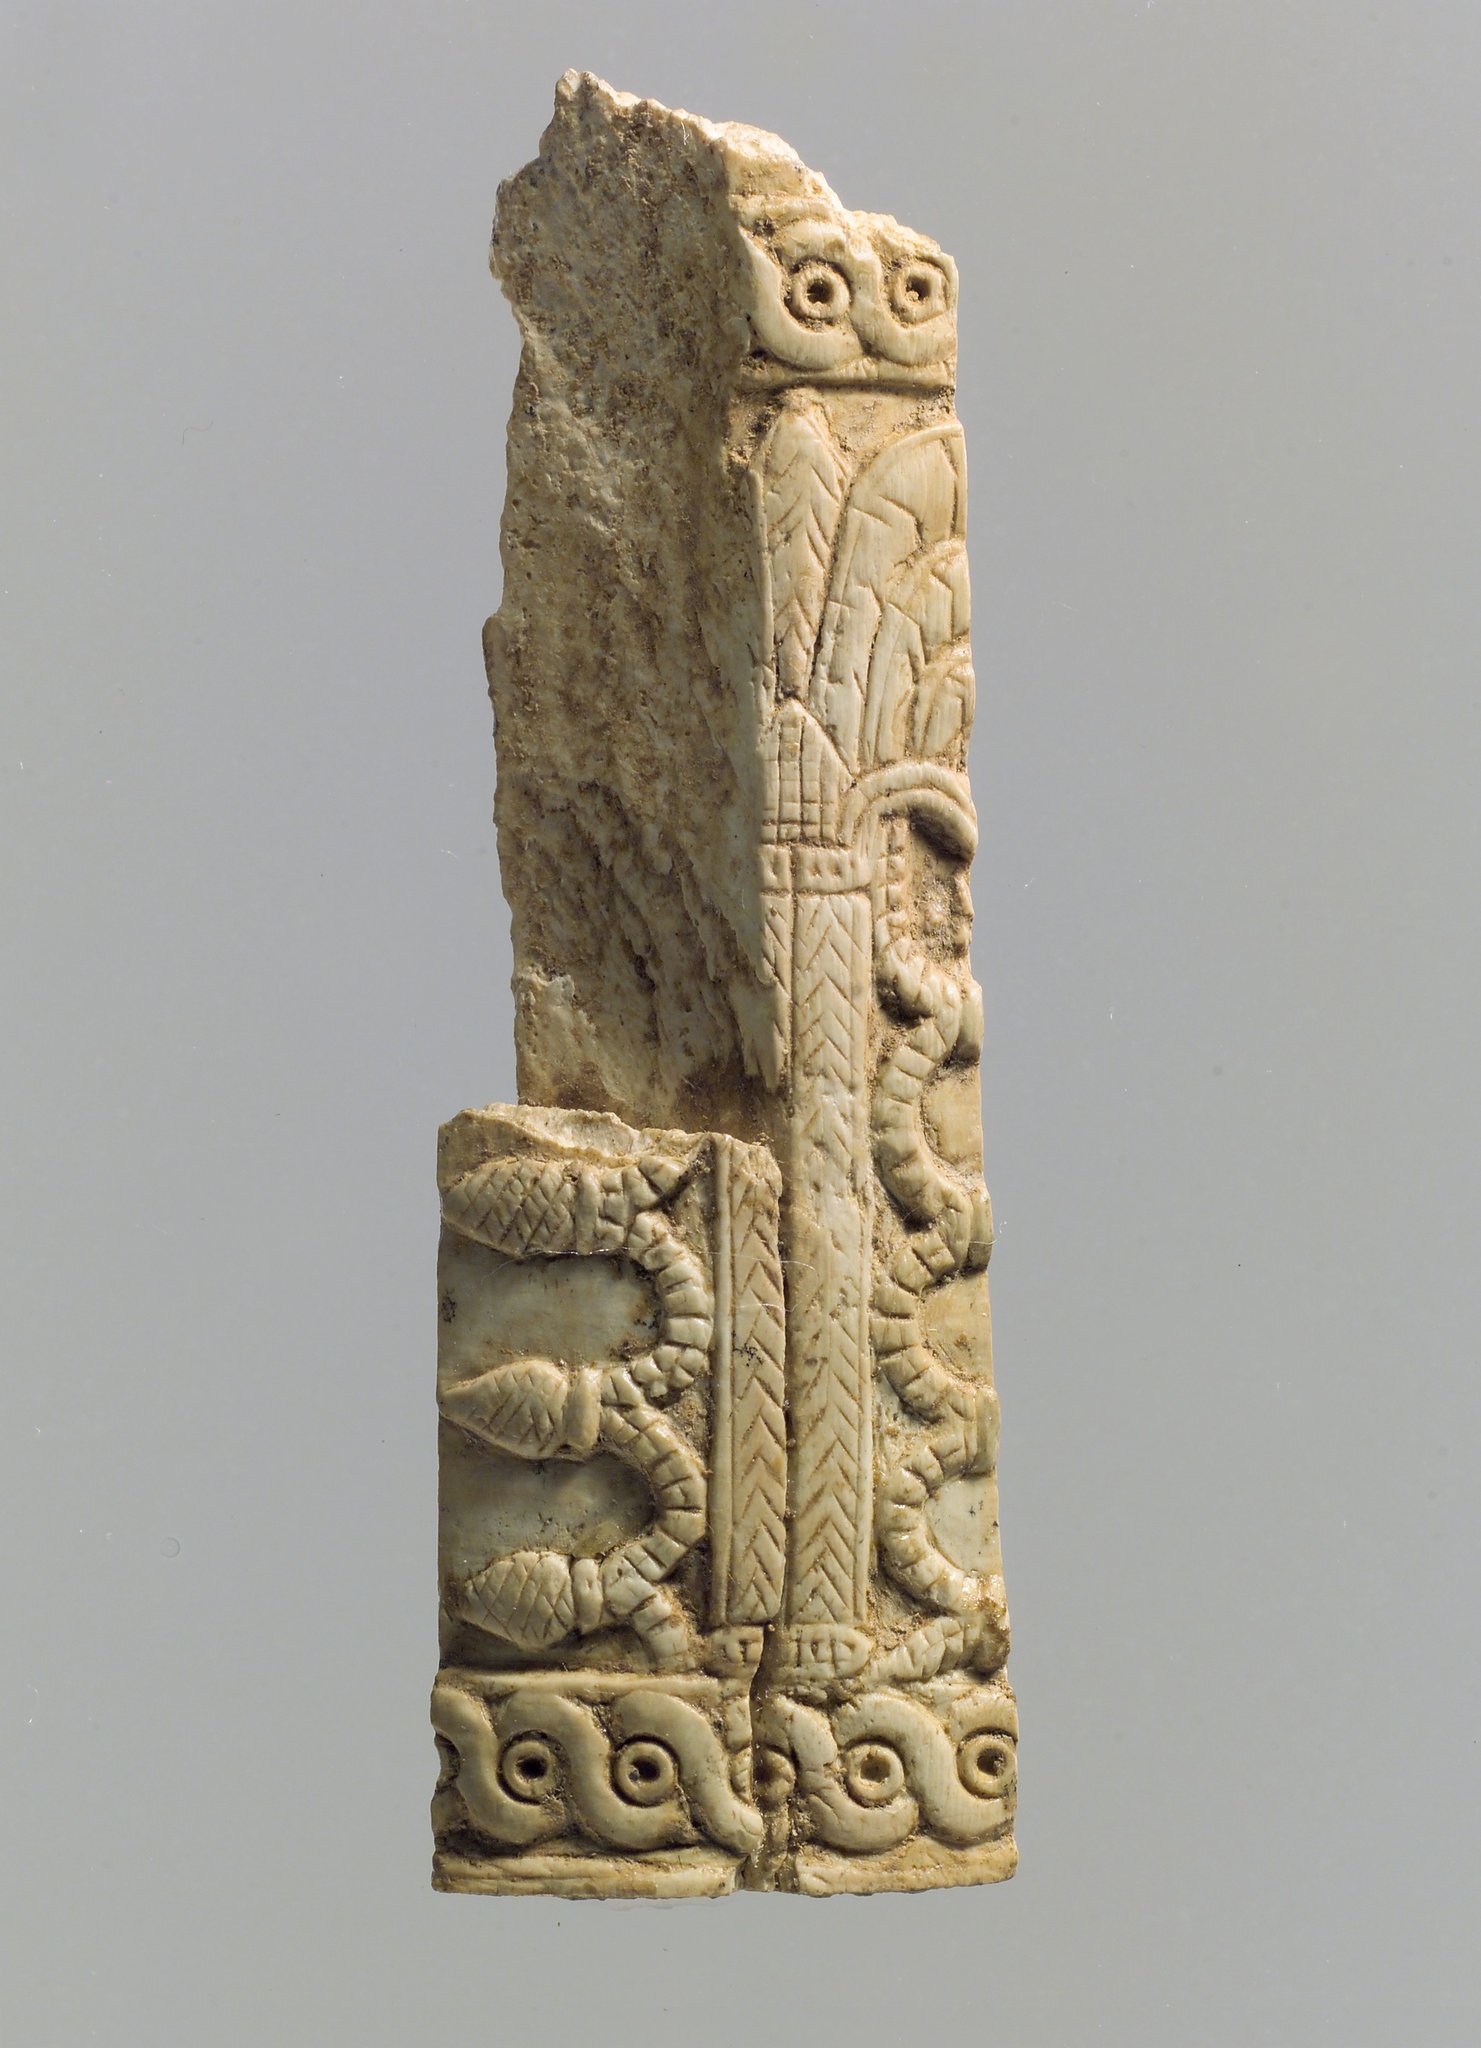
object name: pyxis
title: Pyxis fragment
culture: iranian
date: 800-601 BCE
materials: ivory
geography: iran